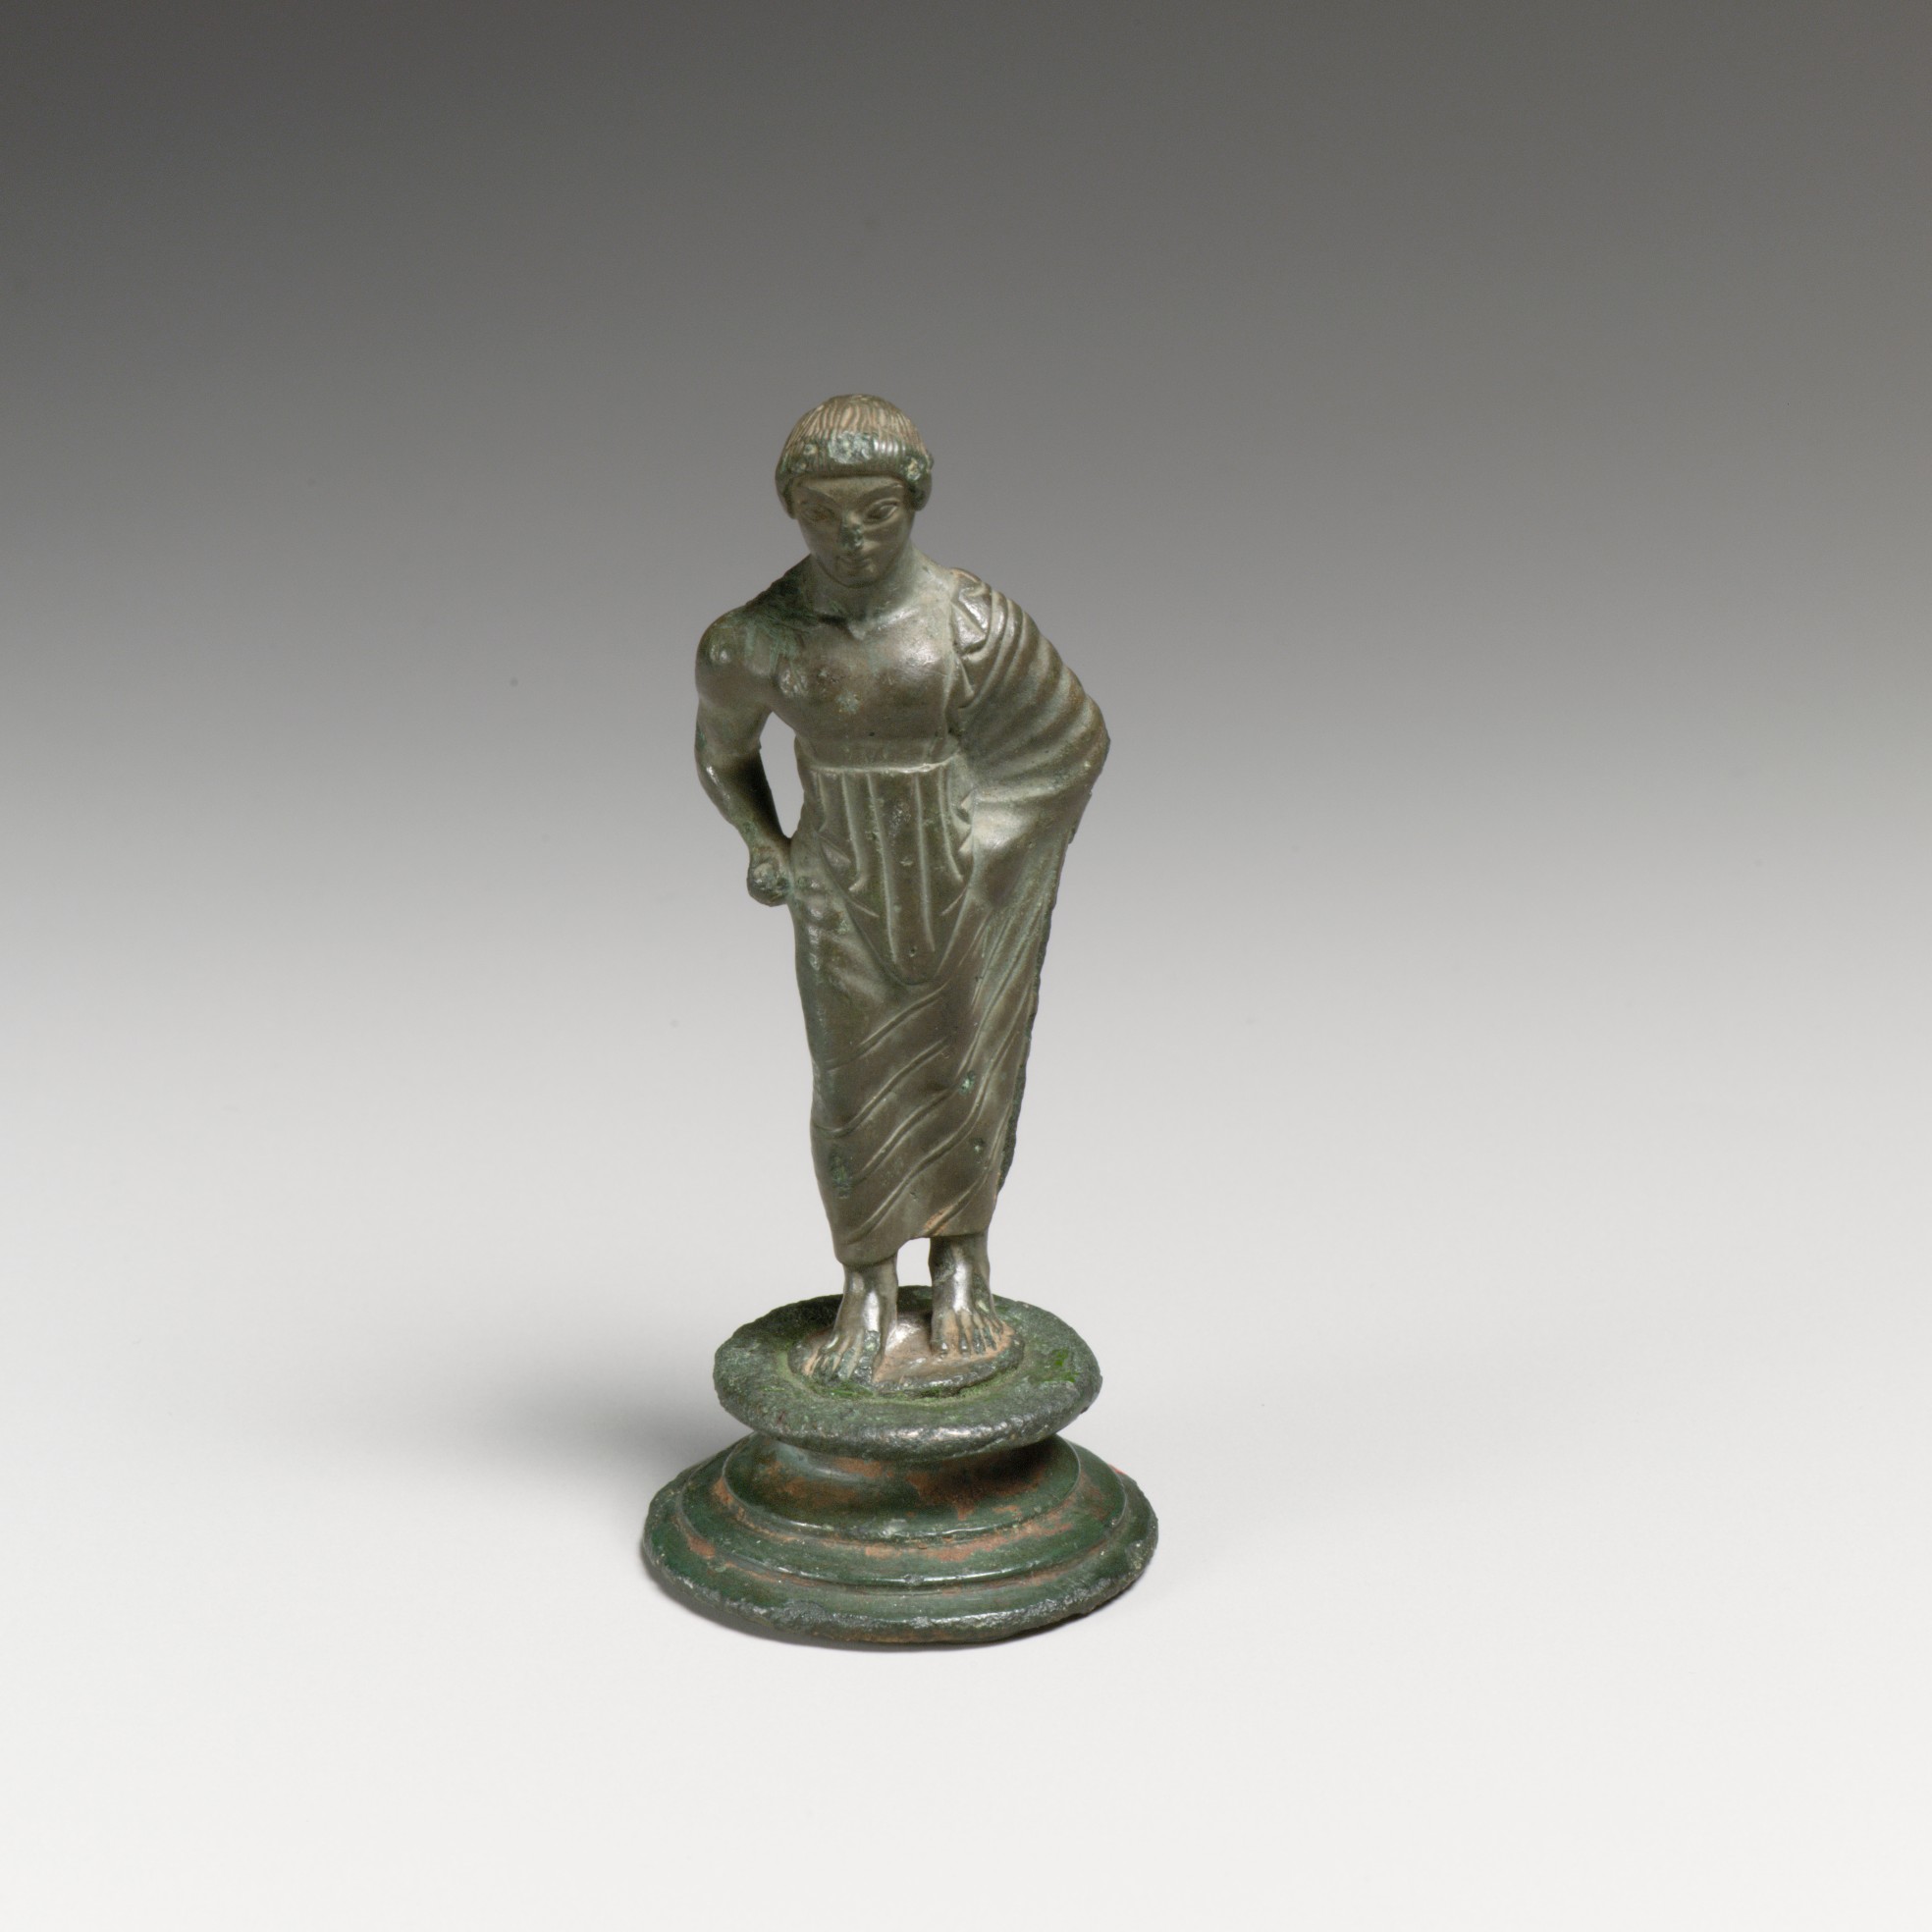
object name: statuette of a youth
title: Bronze statuette of a draped youth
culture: etruscan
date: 500-401 BCE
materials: bronze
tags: human figures